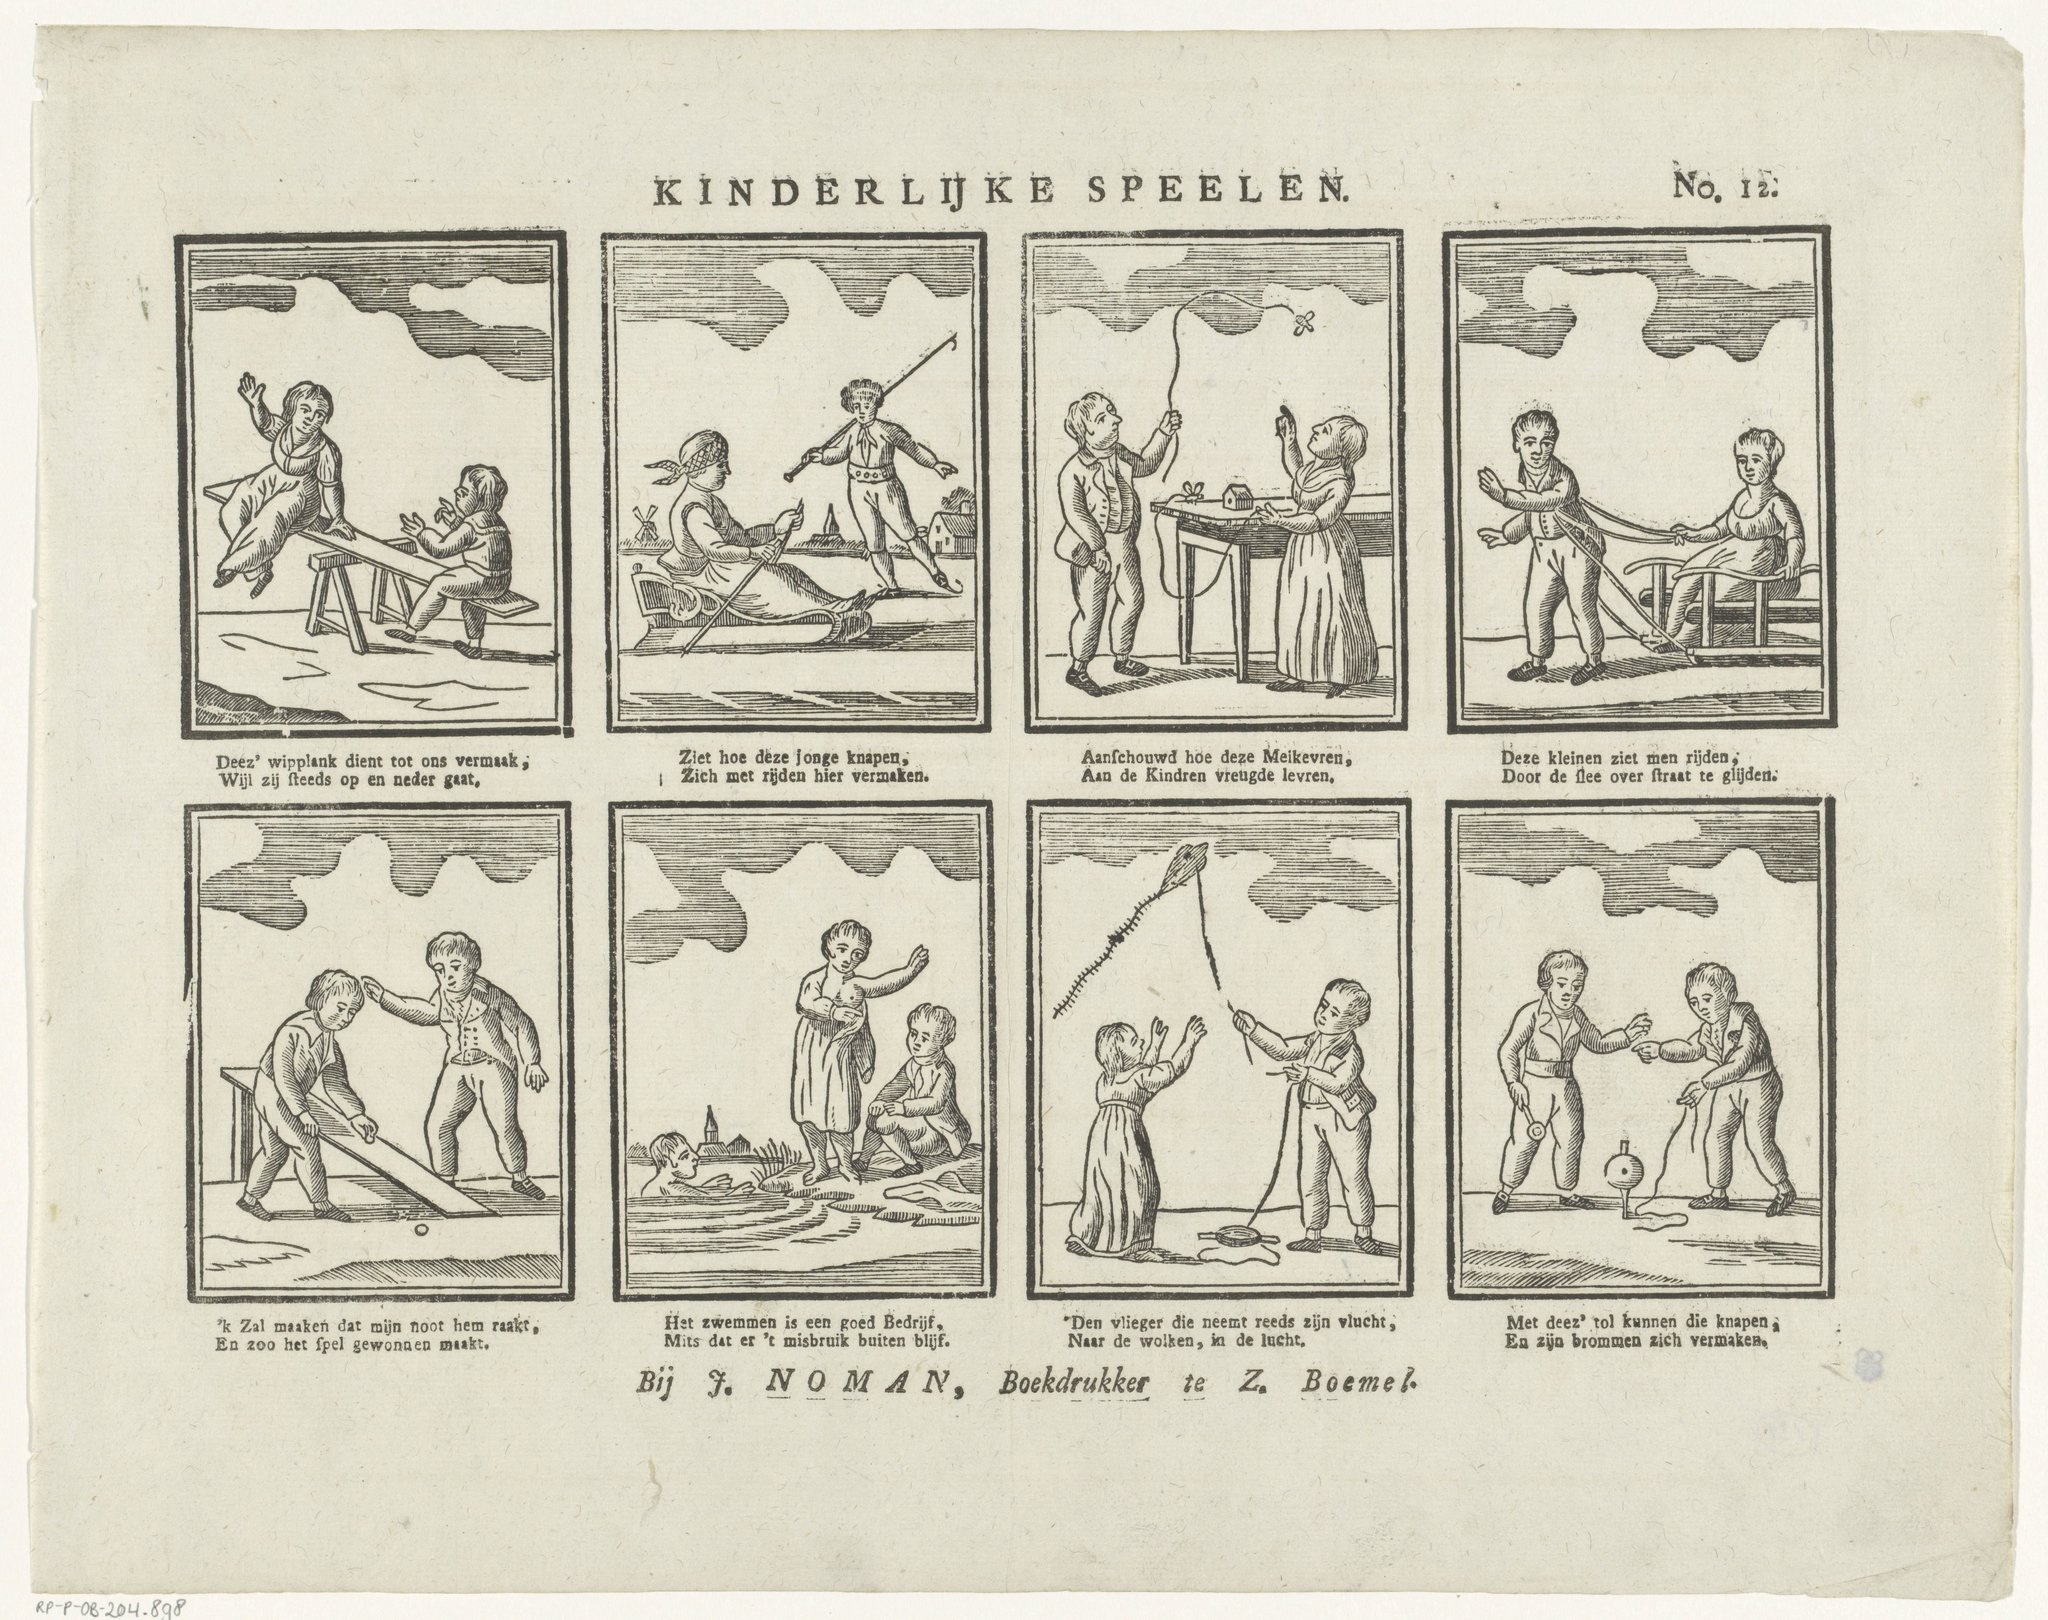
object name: print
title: Kinderlijke speelen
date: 1806-1830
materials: paper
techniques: letterpress printing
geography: zaltbommel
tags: children's games and plays, sleigh, sledge (non-sport), swimming (sport), (flying a) kite, games using special objects (marbles, top, hoop, etc.), seesaw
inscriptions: collector's mark: Lugt 2760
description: Blad met 8 voorstellingen van kinderspelen en bezigheden, zoals wippen, zwemmen en vliegeren. Onder elke afbeelding een tweeregelig vers. Genummerd rechtsboven: No. 12.